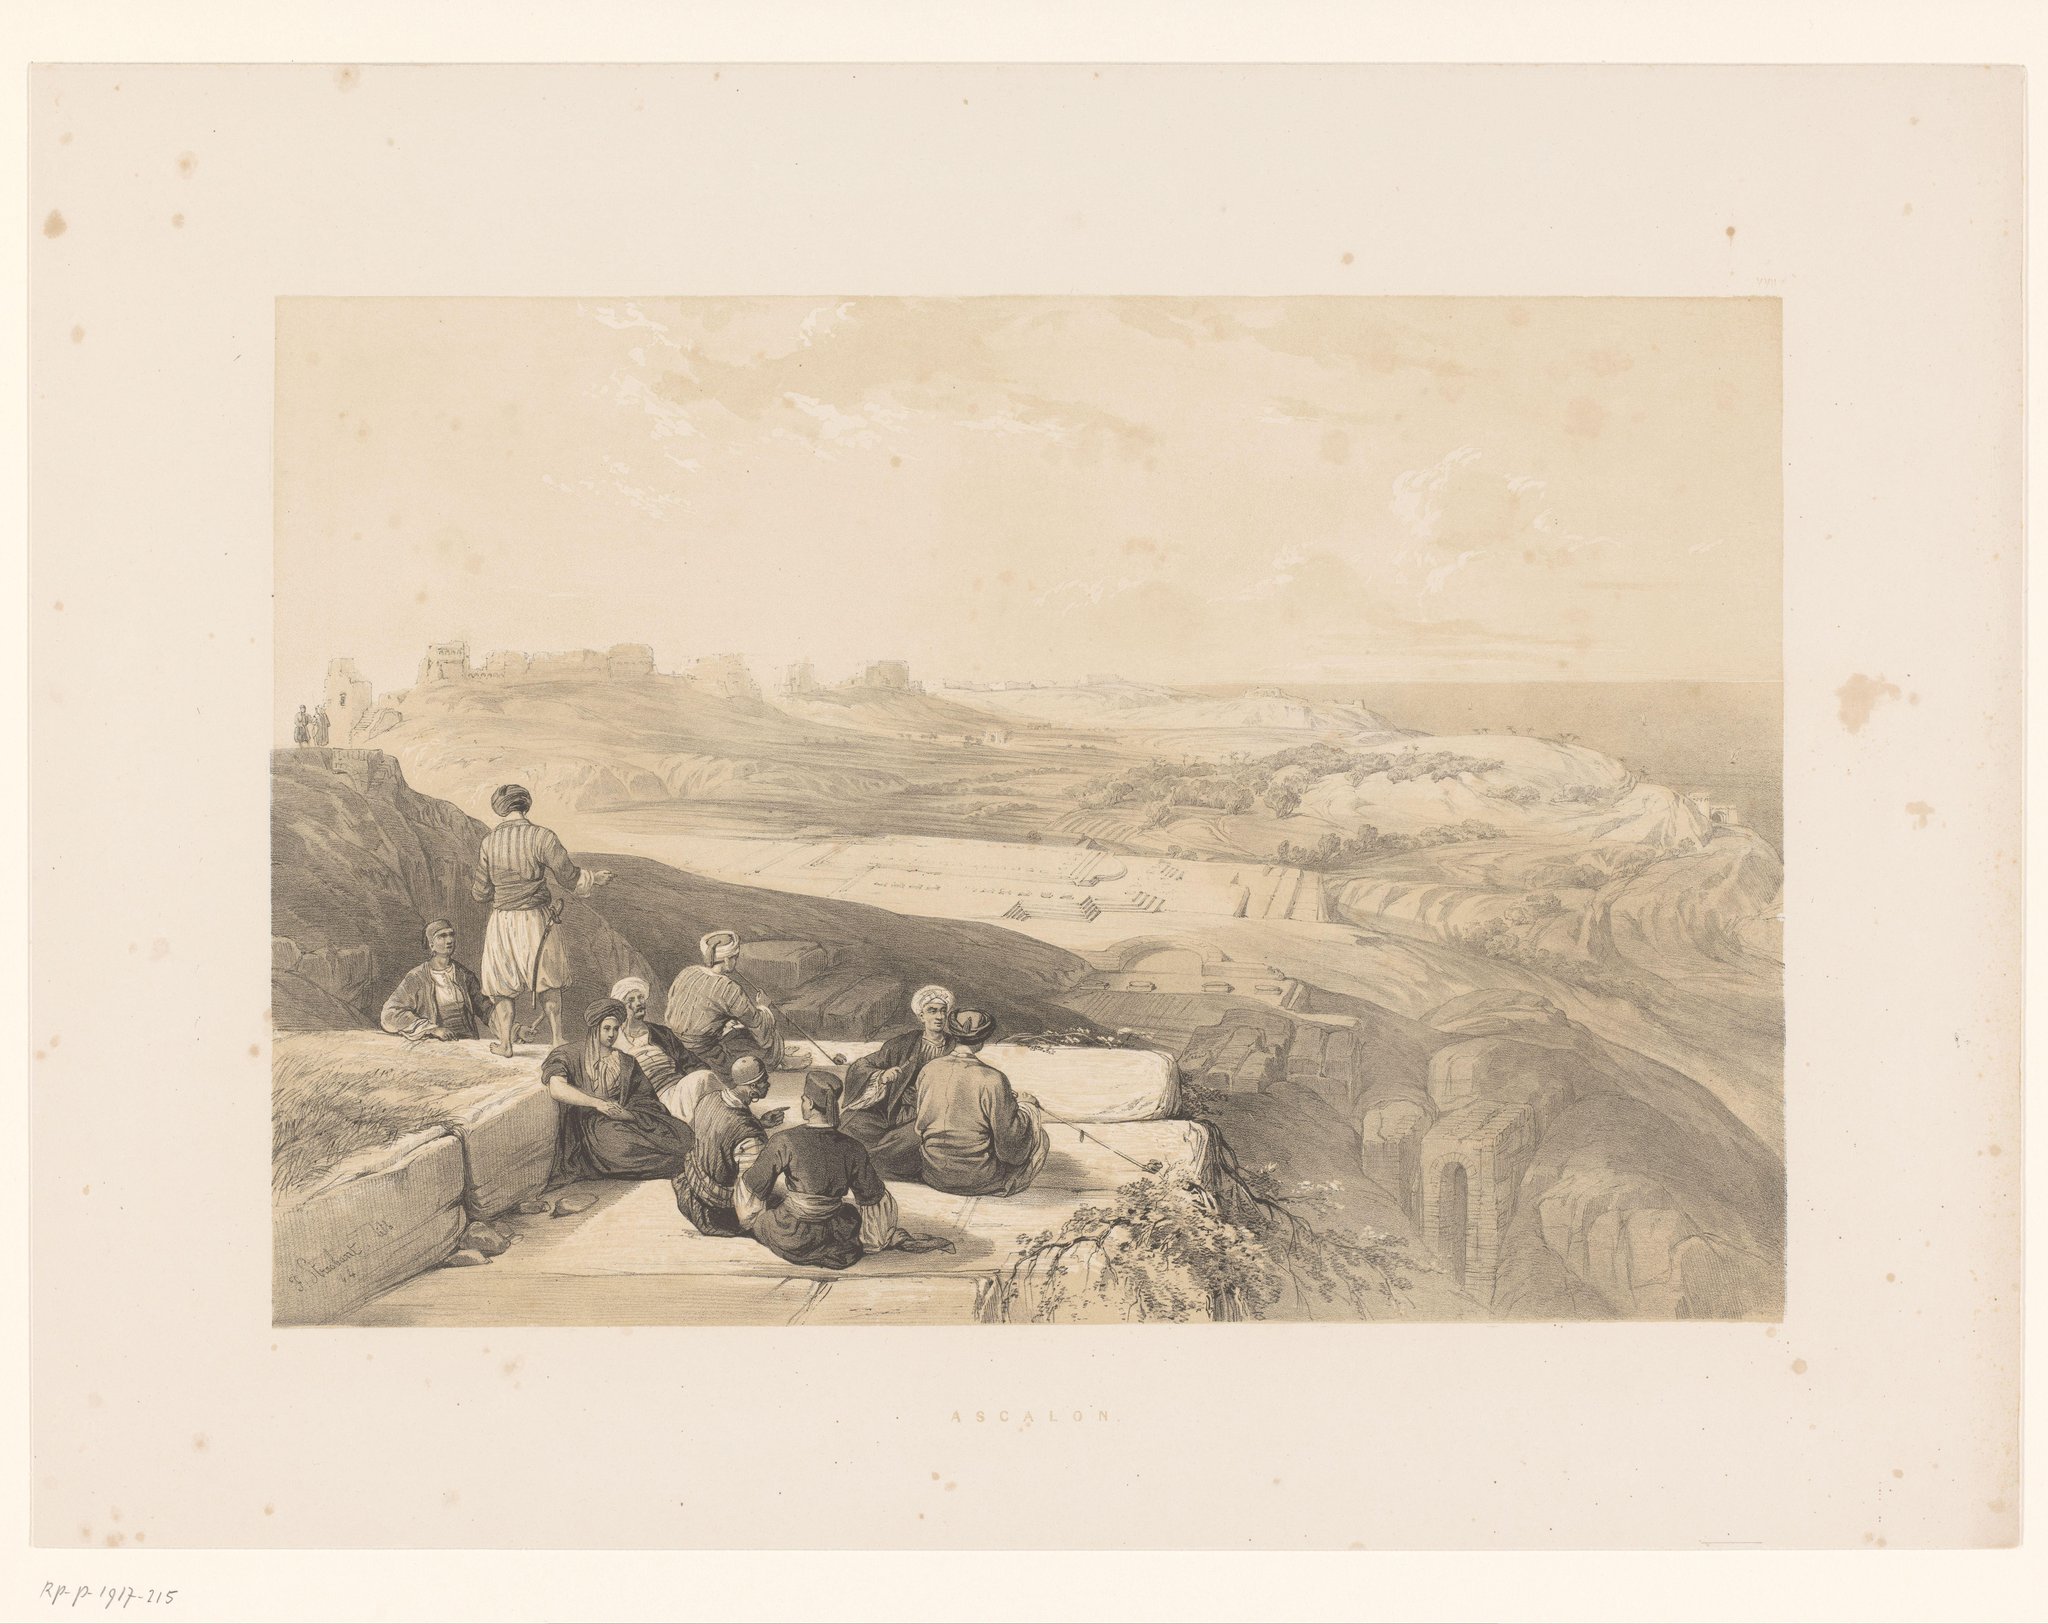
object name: print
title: Ascalon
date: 1852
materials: paper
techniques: tone lithography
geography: brussels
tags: pipe ~ tobacco, coast, city-view, and landscape with man-made constructions (+ city(-scape) with figures, staffage)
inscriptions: collector's mark: Lugt 2228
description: Jules Géruzet maakt in 1852 een heruitgave van het Belgische werk 'La terre sainte. Vues et monuments recueillis par David Roberts de l'Académie de Londres' dat tussen 1843-1845 wordt gedrukt door J. Lots en waarvan de prenten, op verzoek van de Société des Beaux-Arts, door Ghemar en Stroobant worden uitgevoerd naar werken van Haghe.